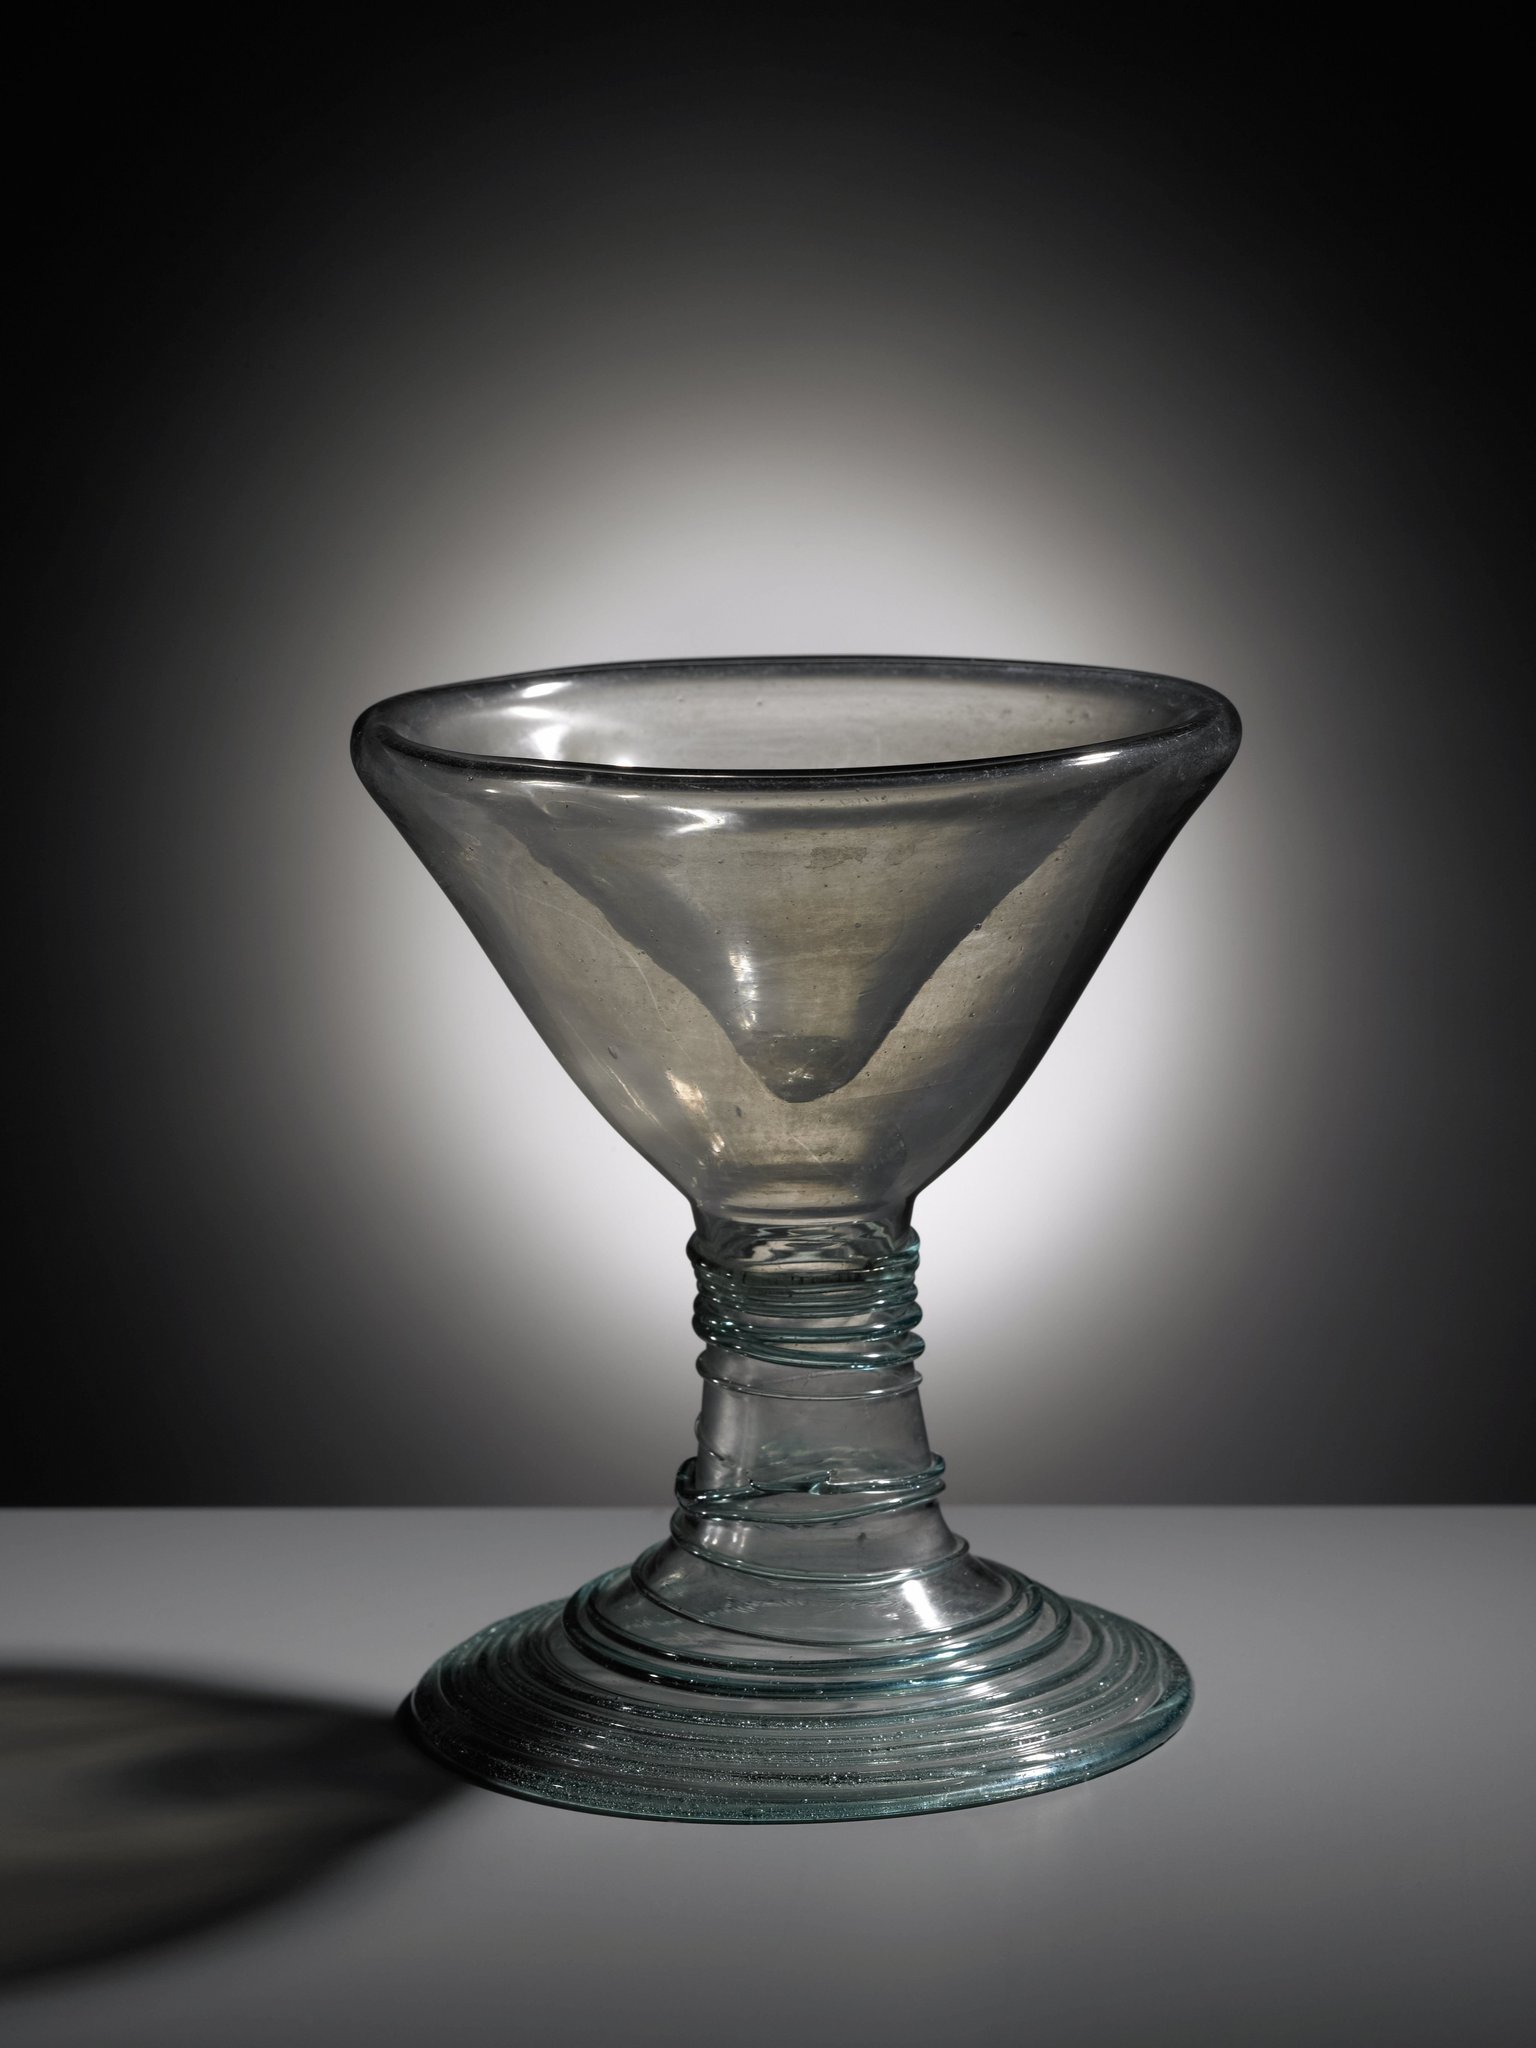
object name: salt condiment vessel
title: Zoutvat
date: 1600-1799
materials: glass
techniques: façon de venise, glassblowing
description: Zoutvat op brede, lage voet, overgaande in een rechte stam. Om de voet en de stam is een blauw-groene draad gewonden. De trechtervormige kelk, aan één stuk geblazen met de stam, is dubbelwandig door het instulpen van de bovenzijde